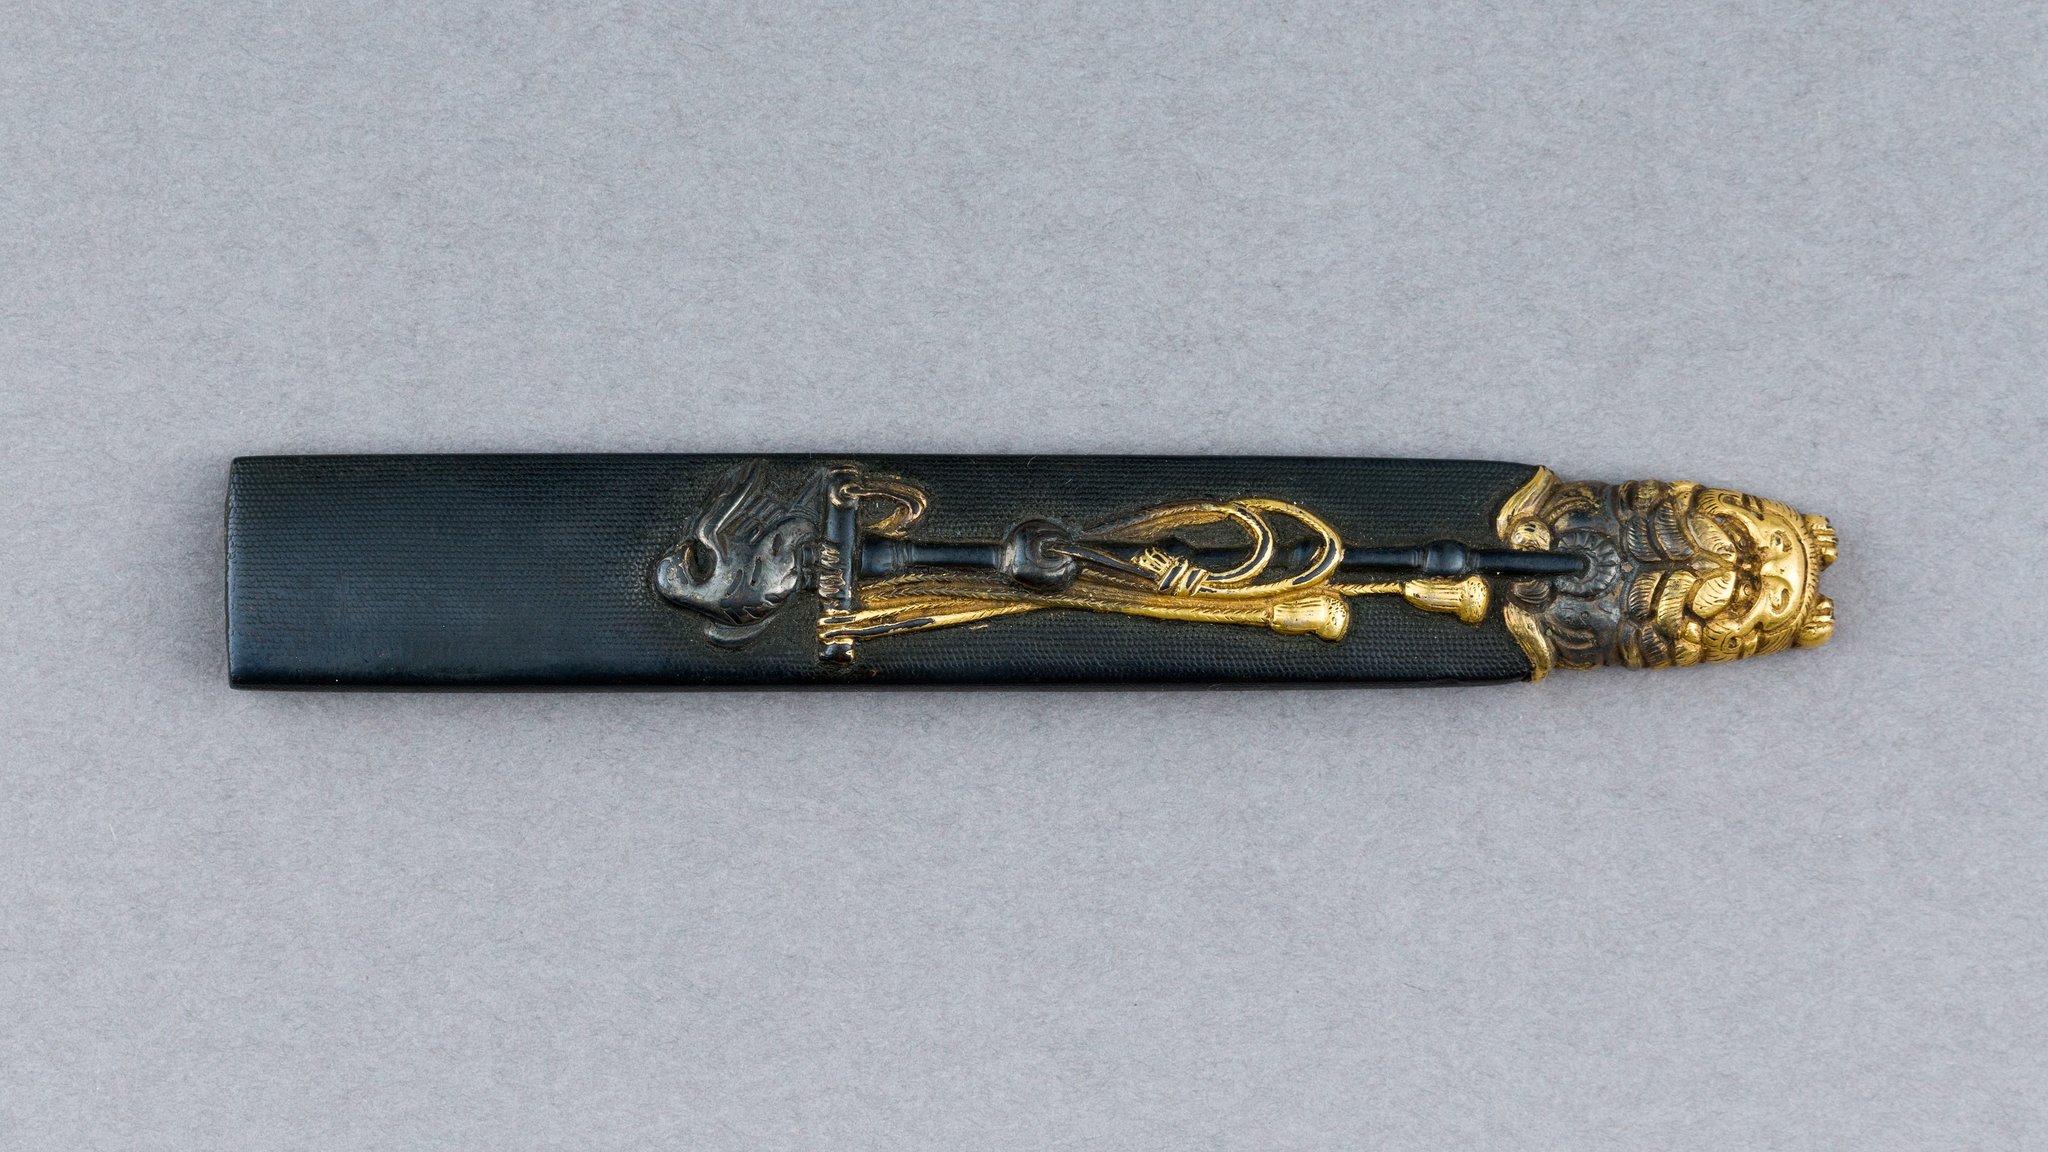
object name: knife handle kozuka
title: Knife Handle (Kozuka)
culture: japanese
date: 1615-1868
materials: gold alloy, gold, silver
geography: japan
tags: birds